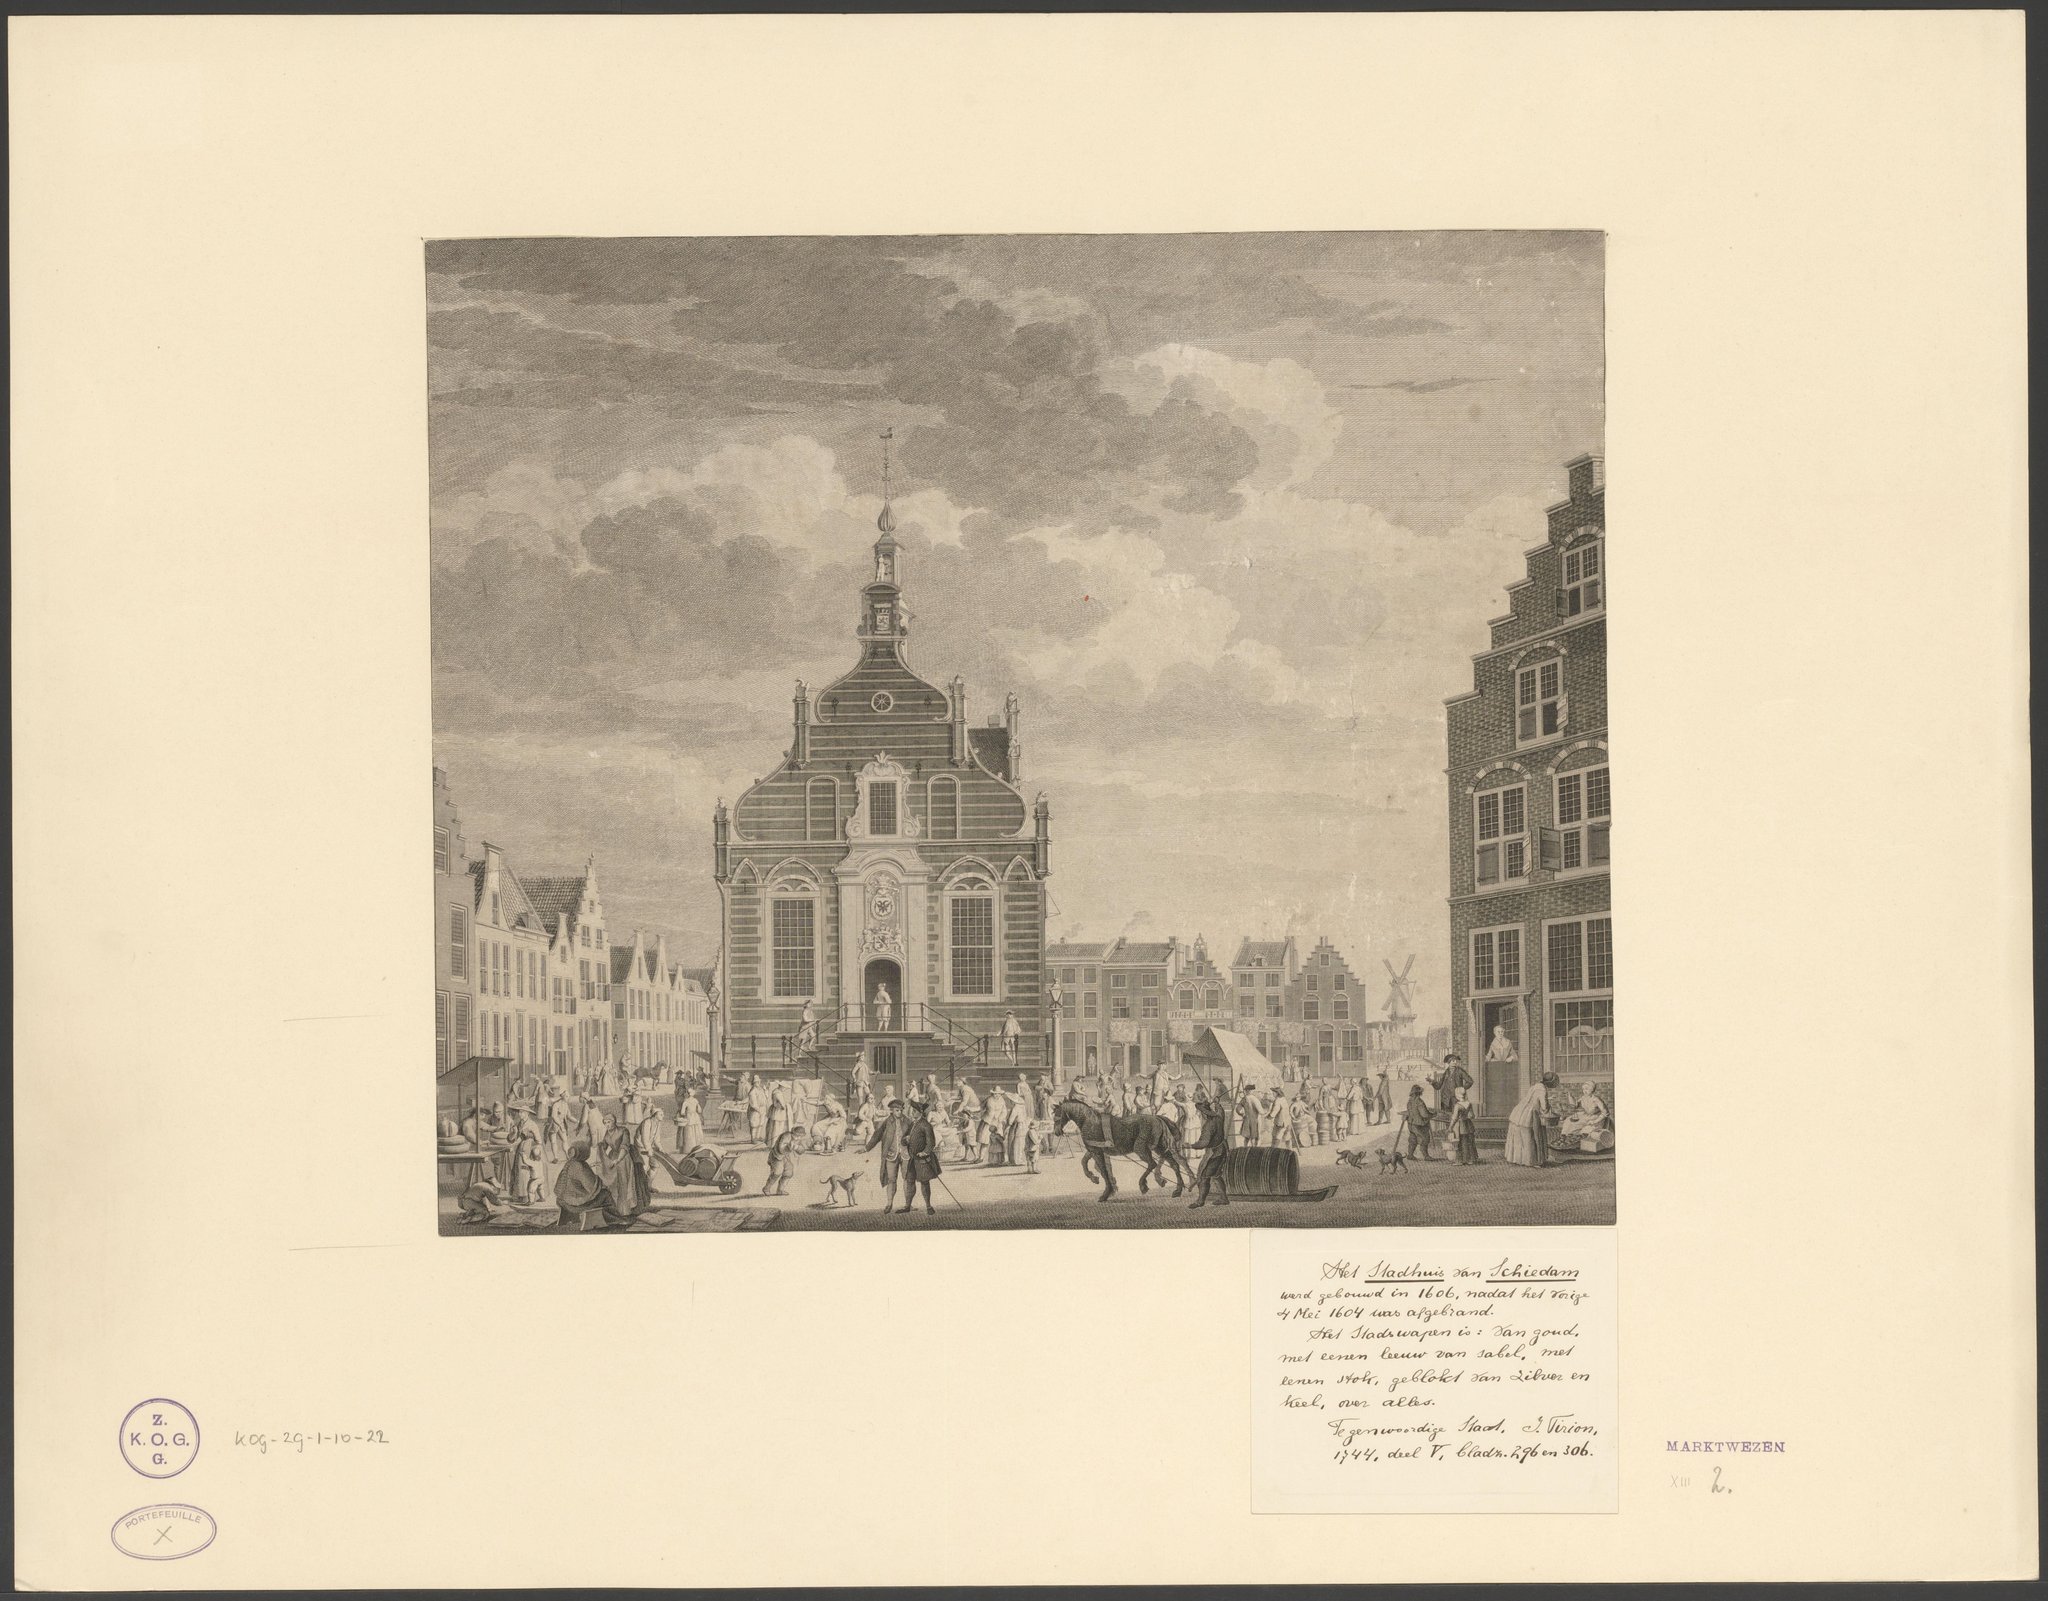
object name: print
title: Gezicht op Grote Markt en het stadhuis te Schiedam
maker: leendert brasser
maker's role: draughtsman, print maker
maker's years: 1727-1793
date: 1777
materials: paper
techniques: etching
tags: townhall, market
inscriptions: collector's mark: Lugt 1641, stamp, stamp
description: Gezicht op de Grote Markt met het Oude Stadhuis te Schiedam. Onderwerpsrubrieken binnen de Atlas Zeden en Gewoonten: Handel, nijverheid en verkeer, Marktwezen, Schiedam.